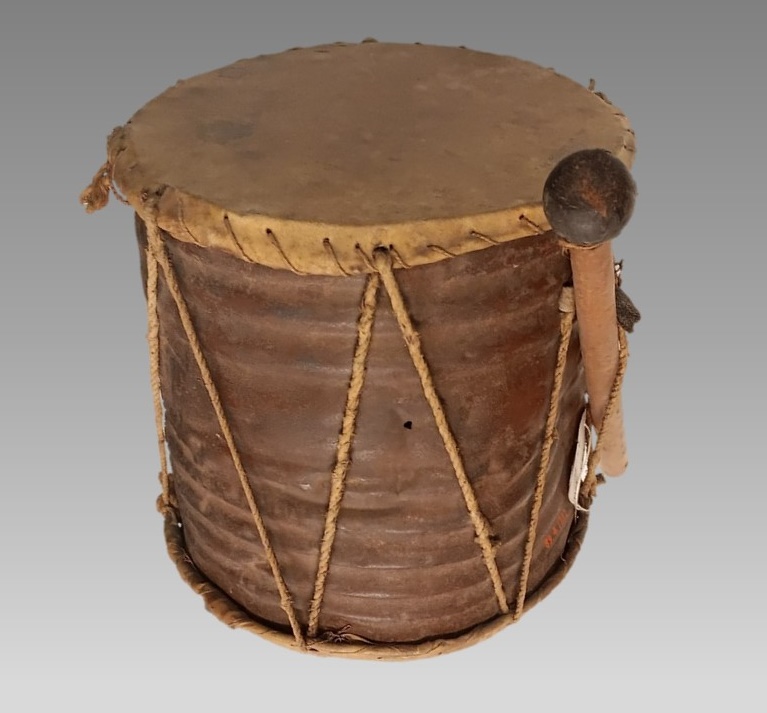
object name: drum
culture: melanesian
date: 1867-1900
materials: cord, metal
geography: papua new guinea